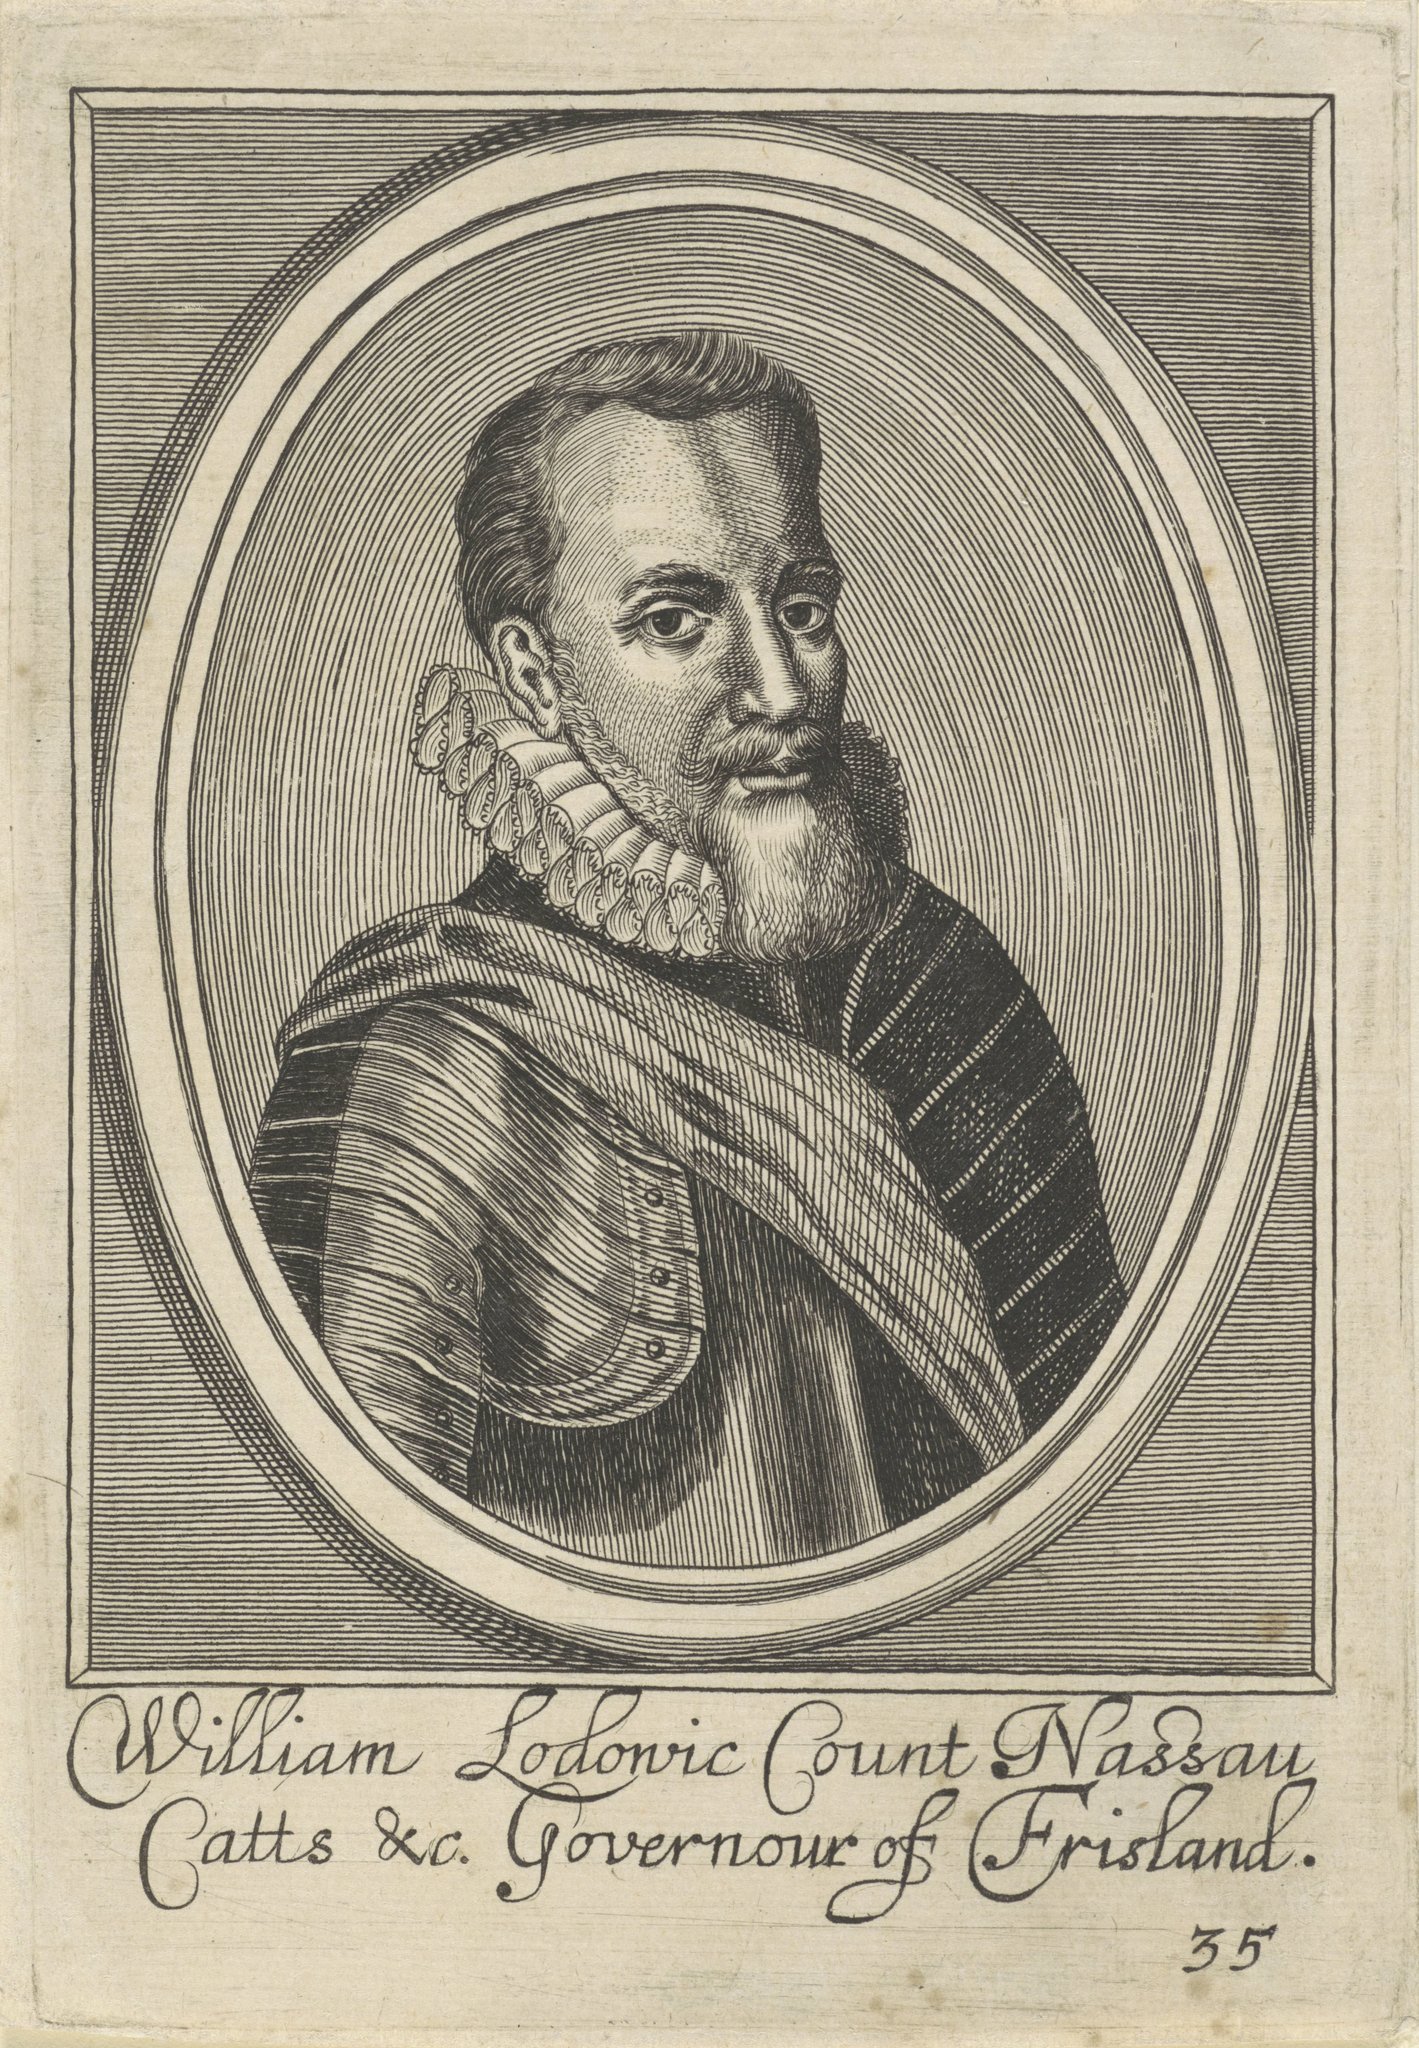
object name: print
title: Portret van Willem Lodewijk, graaf van Nassau-Dillenburg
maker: Anonymous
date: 1600-1699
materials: paper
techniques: engraving, etching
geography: low countries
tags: willem lodewijk graaf van nassau-dillenburg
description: De hier vermelde titel verwijst naar de hoogst verkregen titel van de geportretteerde, niet per se naar de titel die de geportretteerde op deze voorstelling draagt.